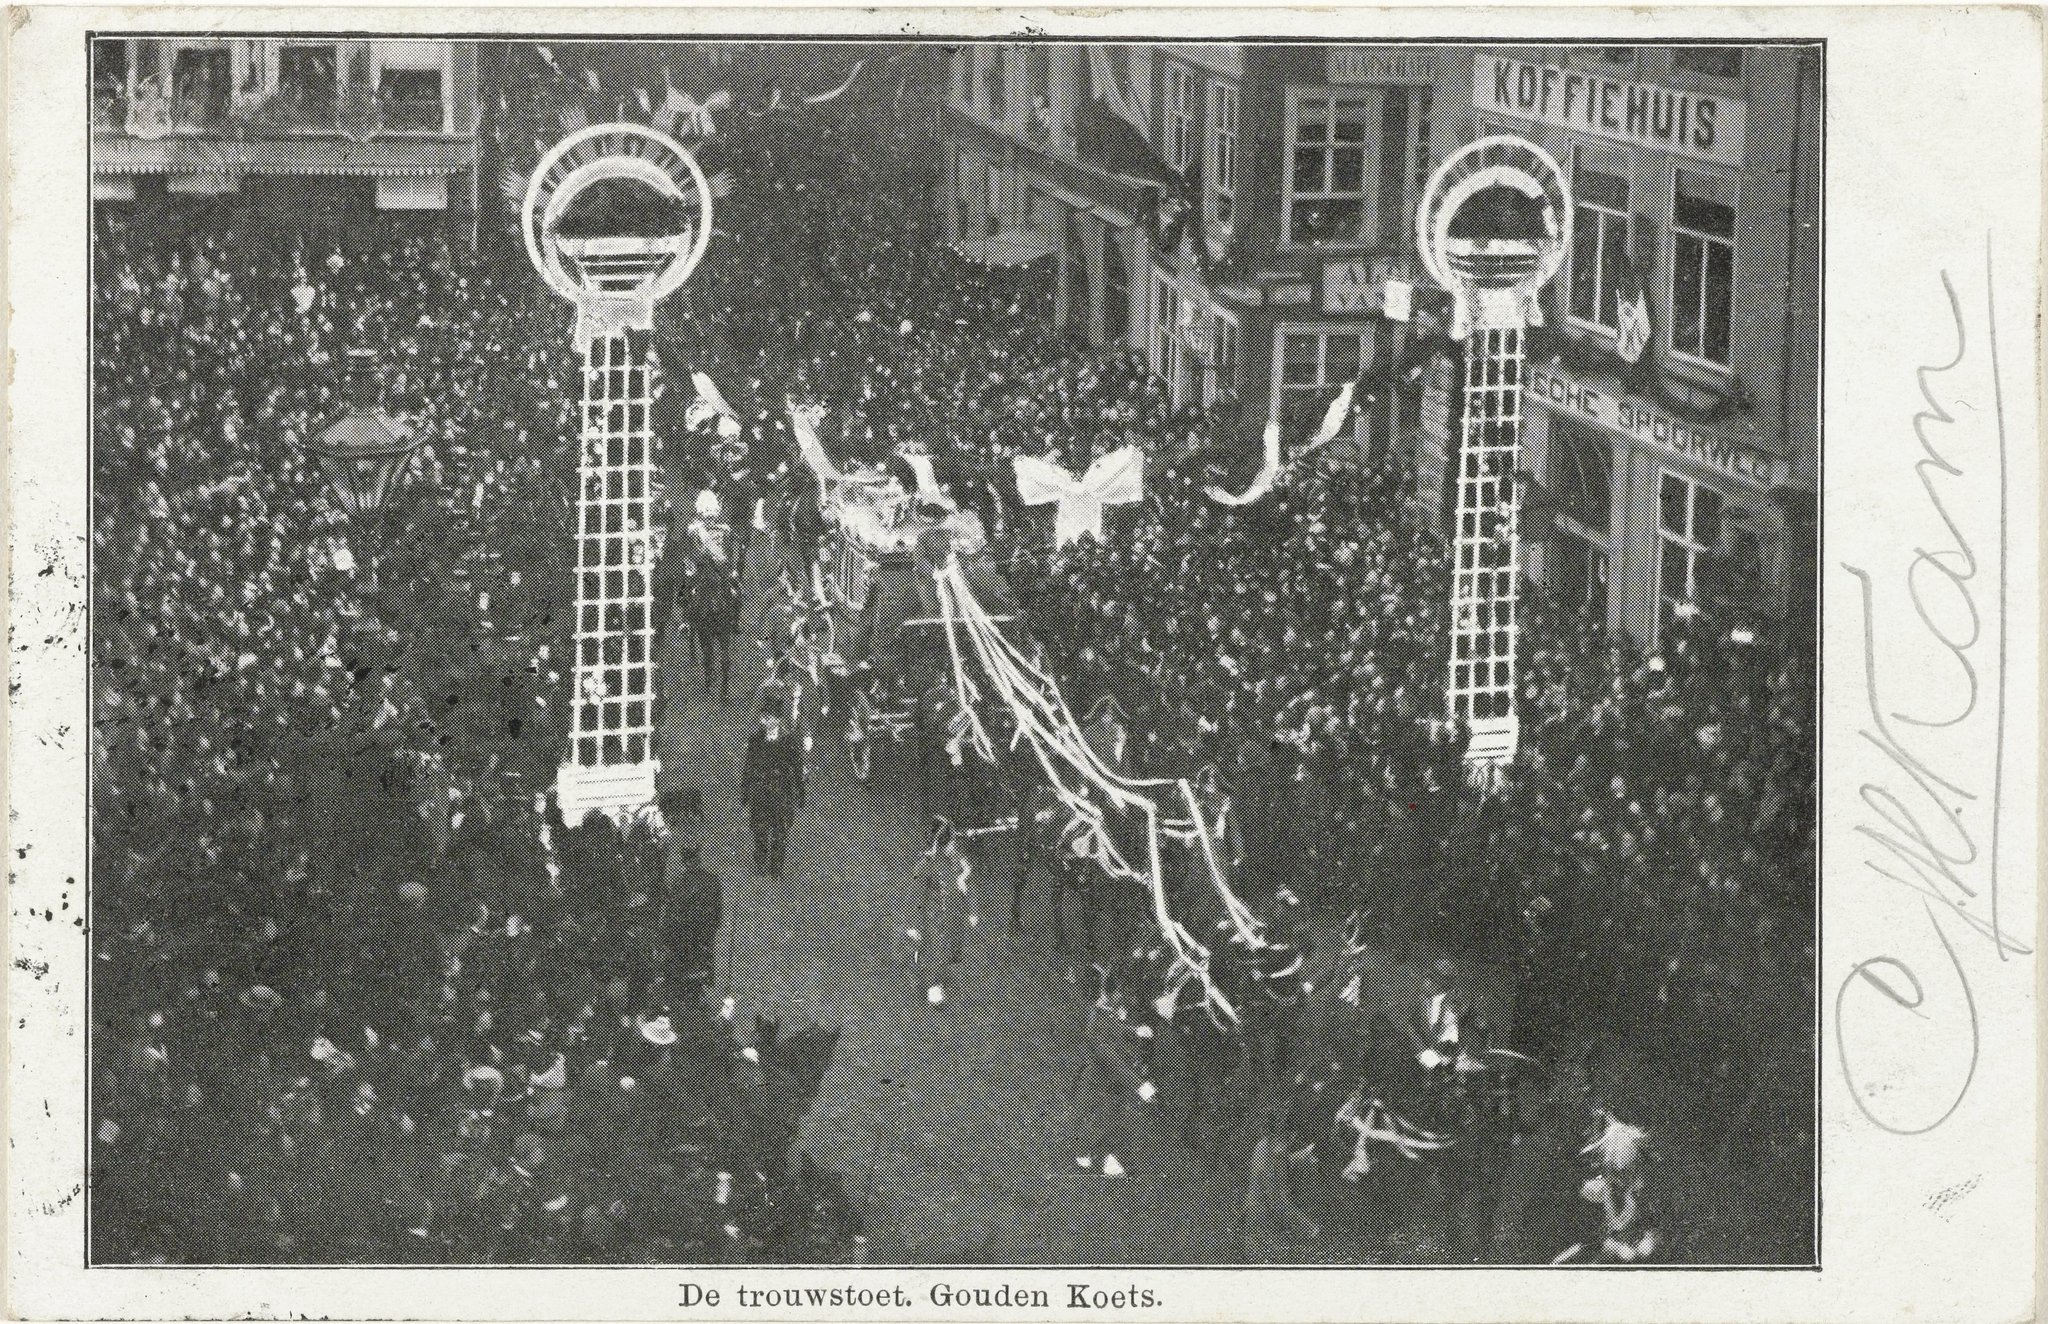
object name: ansichtkaart, prentbriefkaart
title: De gouden koets van de huwelijksstoet van Wilhelmina, koningin der Nederlanden, en Hendrik van Mecklenburg-Schwerin te Den Haag op 7 februari 1901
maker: Anonymous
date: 1901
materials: paper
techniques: autotype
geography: netherlands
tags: wilhelmina of the netherlands, the hague, hendrik (prins der nederlanden (1876-1934)), animal traction, animal-drawn vehicle (carriage etc.), (civil) marriage ceremonies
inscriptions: inscription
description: De hier vermelde titel verwijst naar de hoogst verkregen titel van de geportretteerde, niet per se naar de titel die de geportretteerde op deze voorstelling draagt.